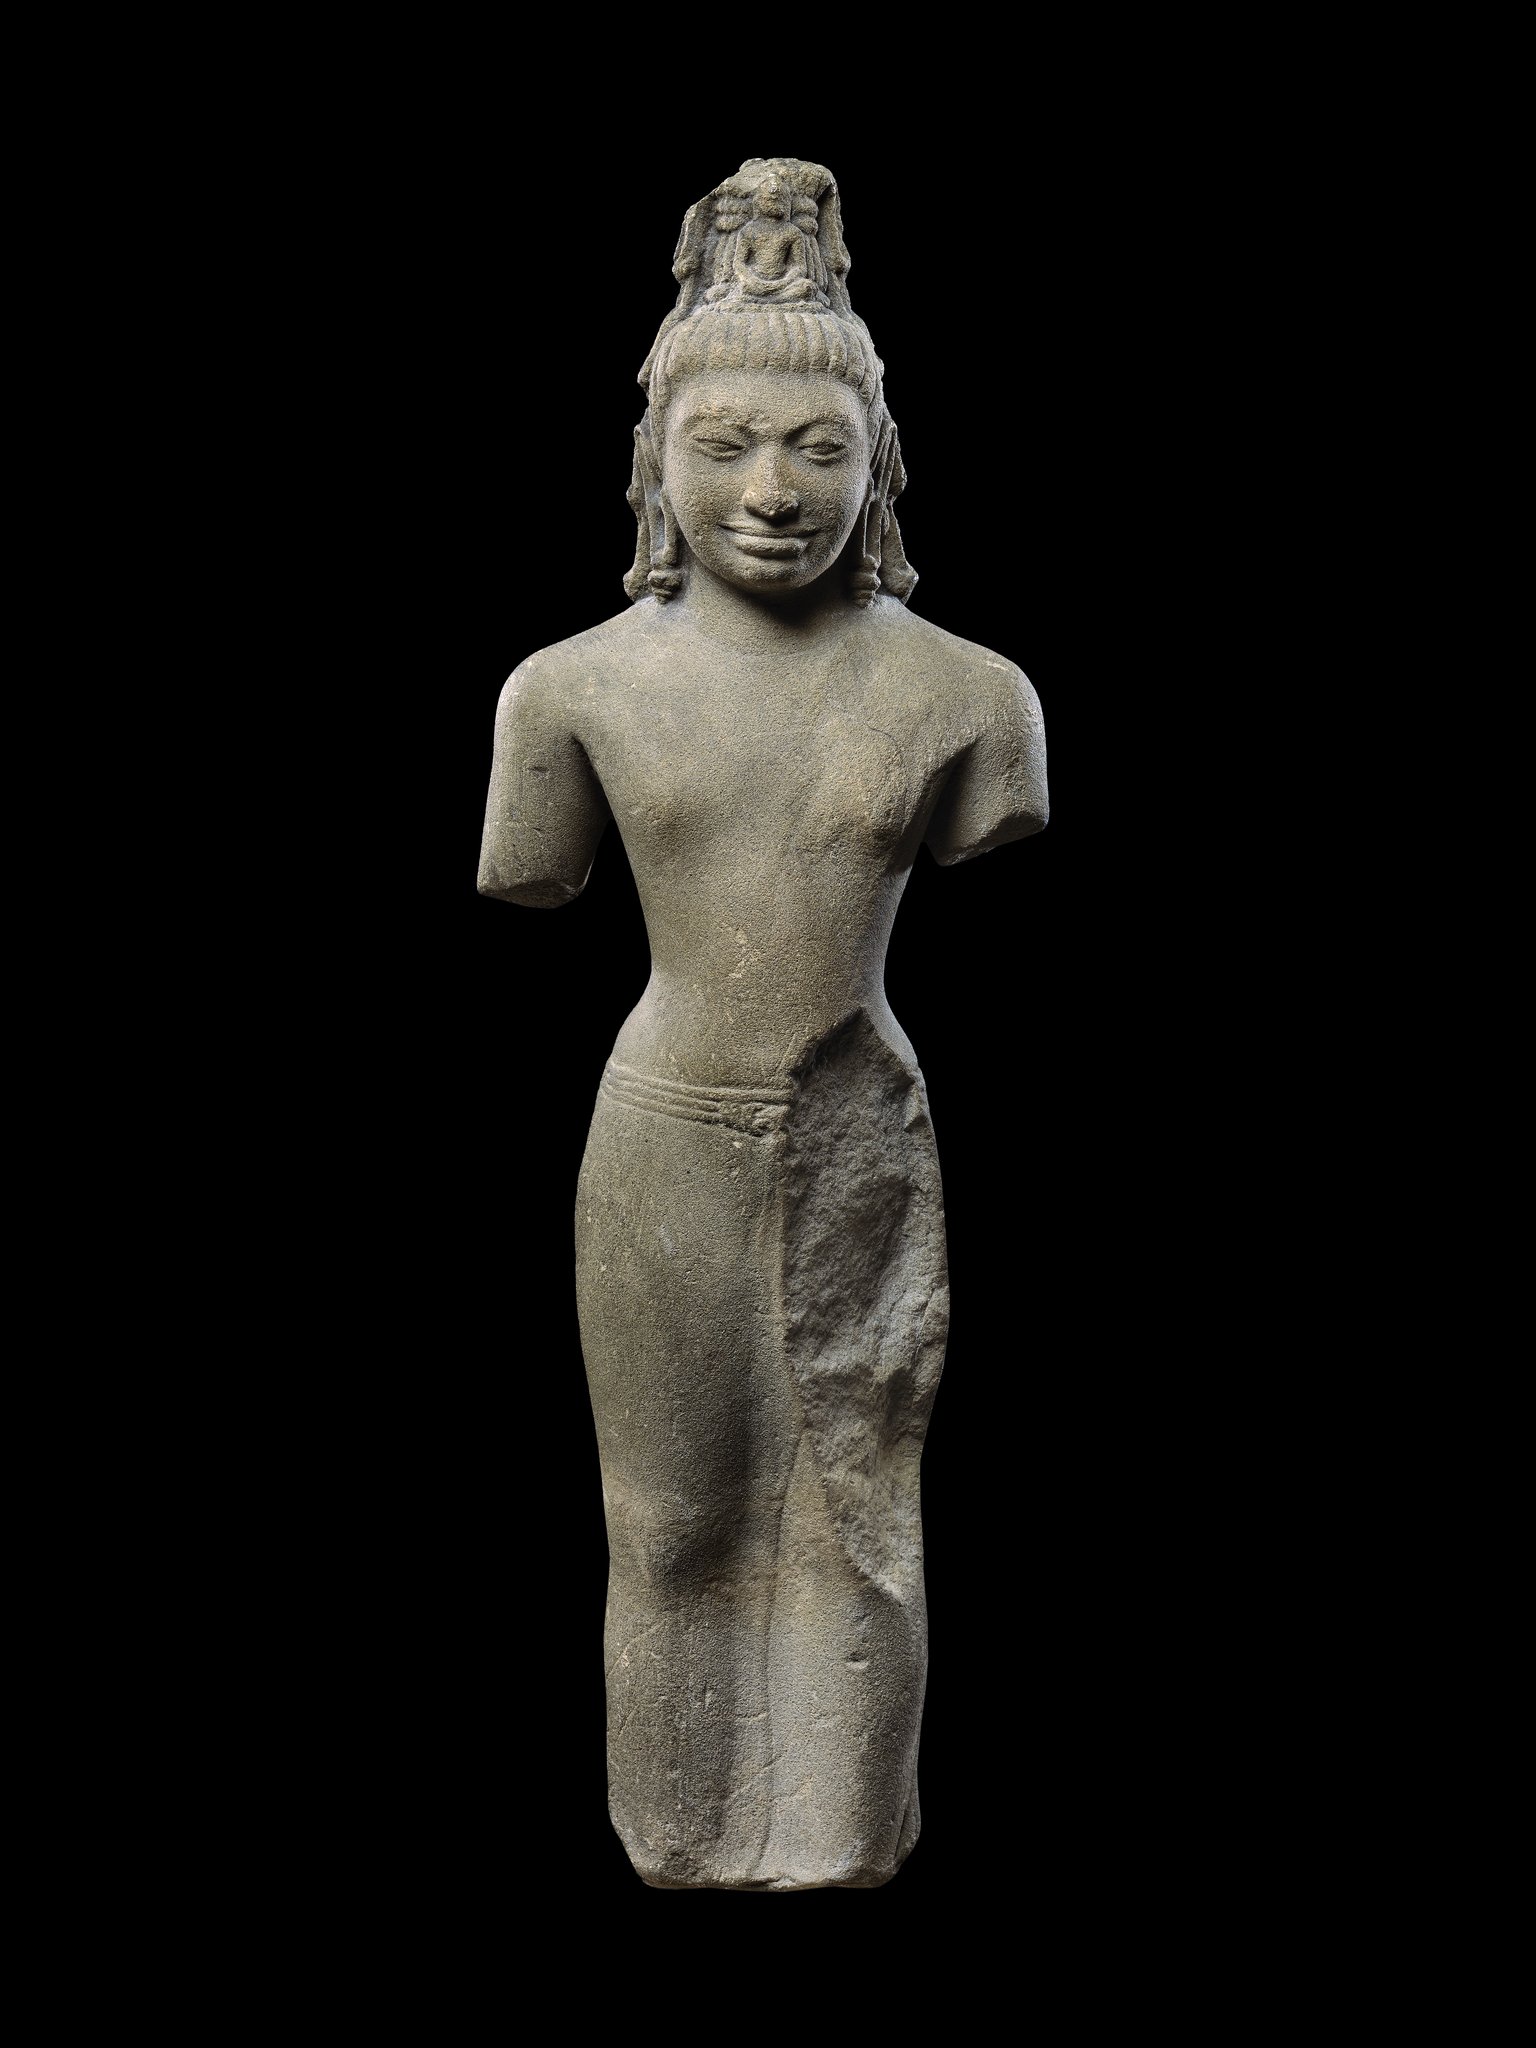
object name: figure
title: Bodhisattva Avalokiteshvara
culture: southern thai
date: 651-700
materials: stone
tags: buddhism,avalokiteshvara,bodhisattvas